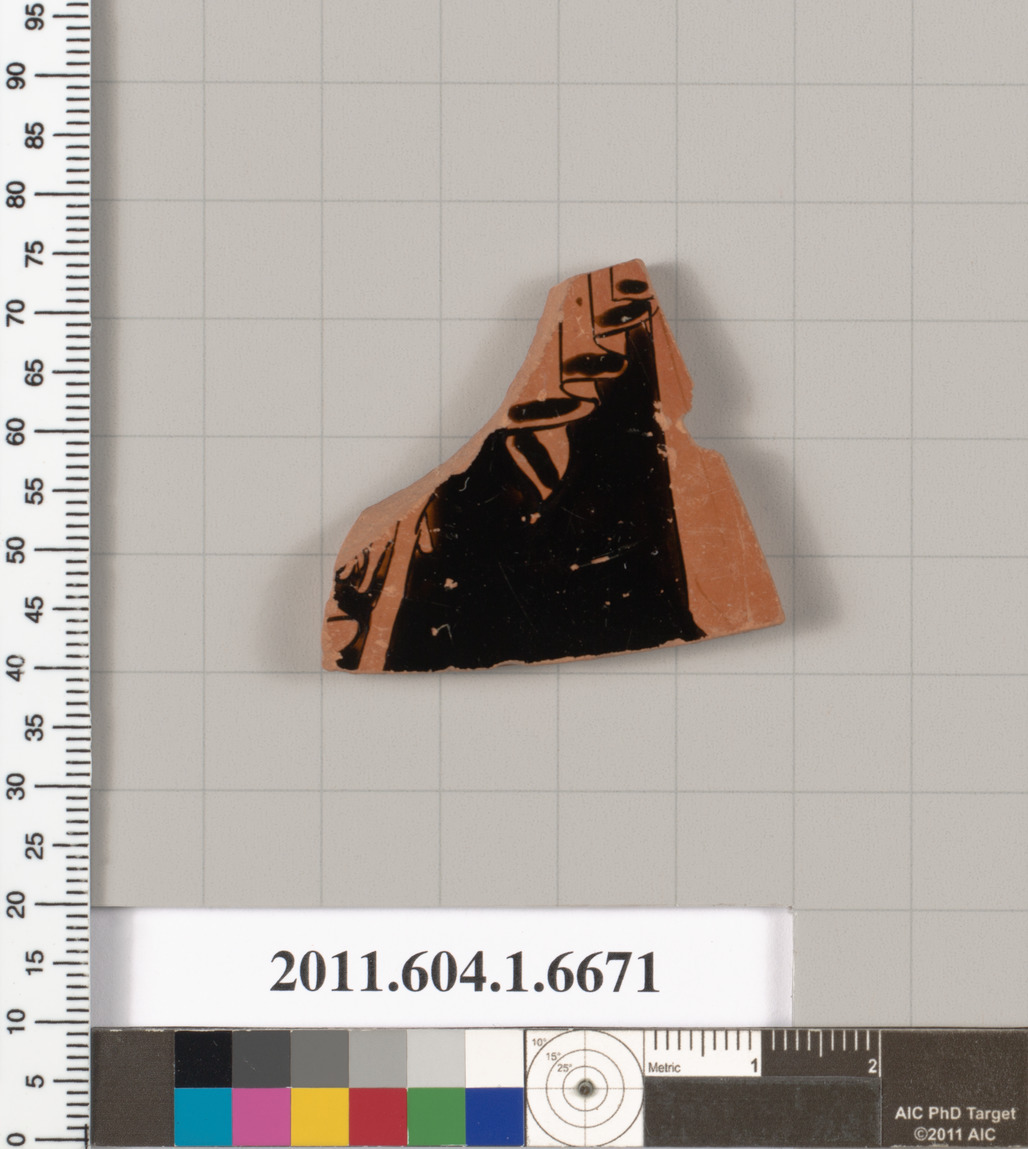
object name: kylix fragment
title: Terracotta fragment of a kylix (drinking cup)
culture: greek, attic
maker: brygan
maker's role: artist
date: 490-470 BCE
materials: terracotta